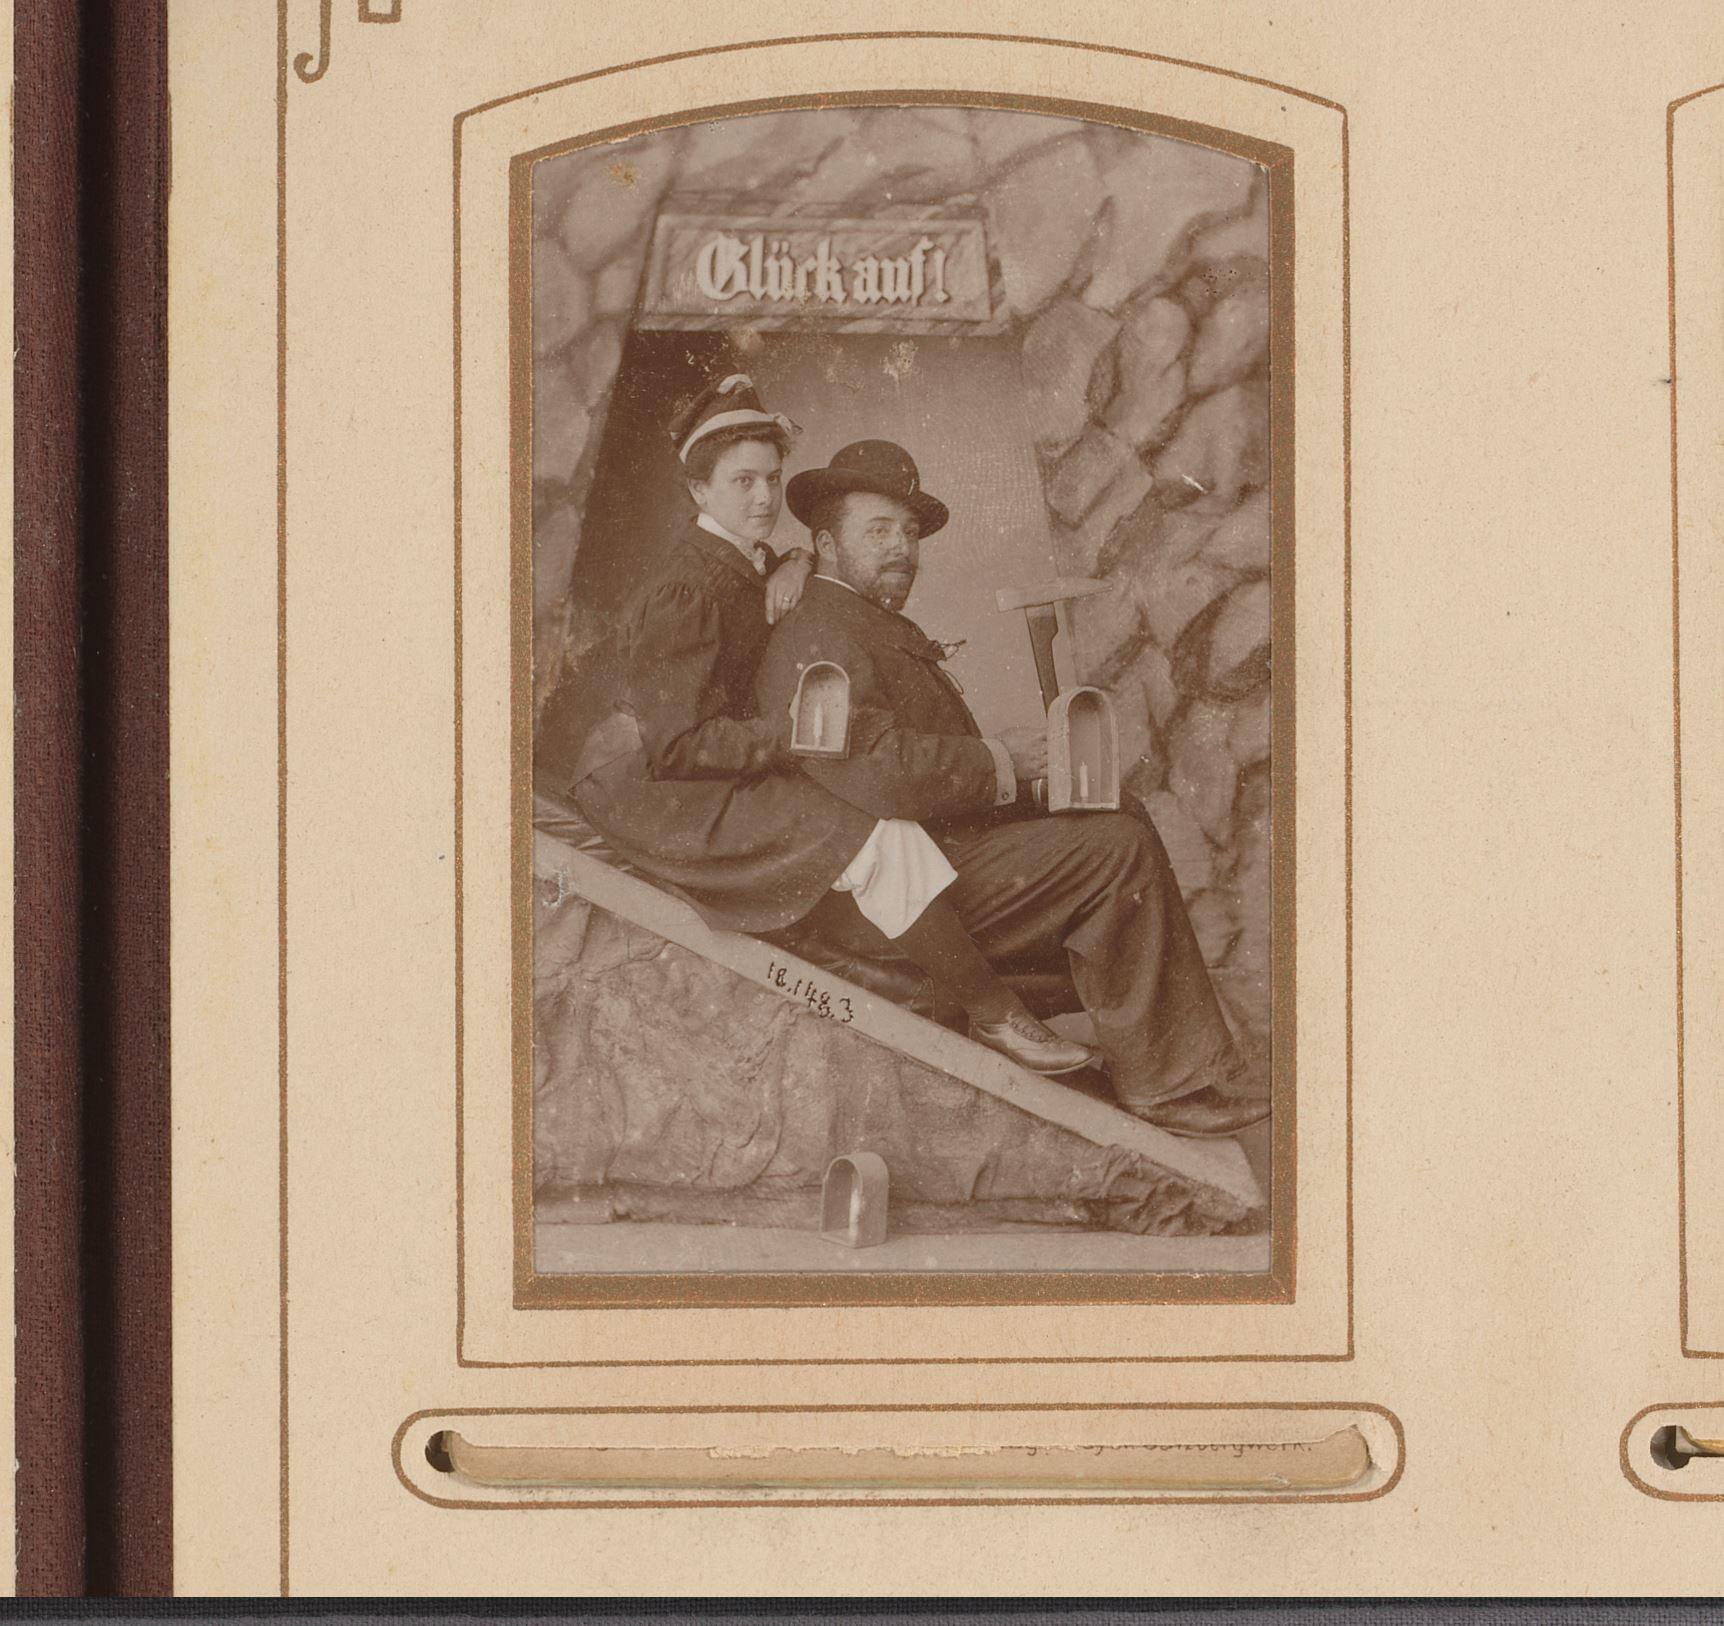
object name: carte de visite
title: Portret van een man en vrouw, zittend in een decor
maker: Anonymous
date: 1890-1910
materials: cardboard, photographic support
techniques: collodion silver print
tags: historical persons - bb - woman, historical persons, head-gear: hat